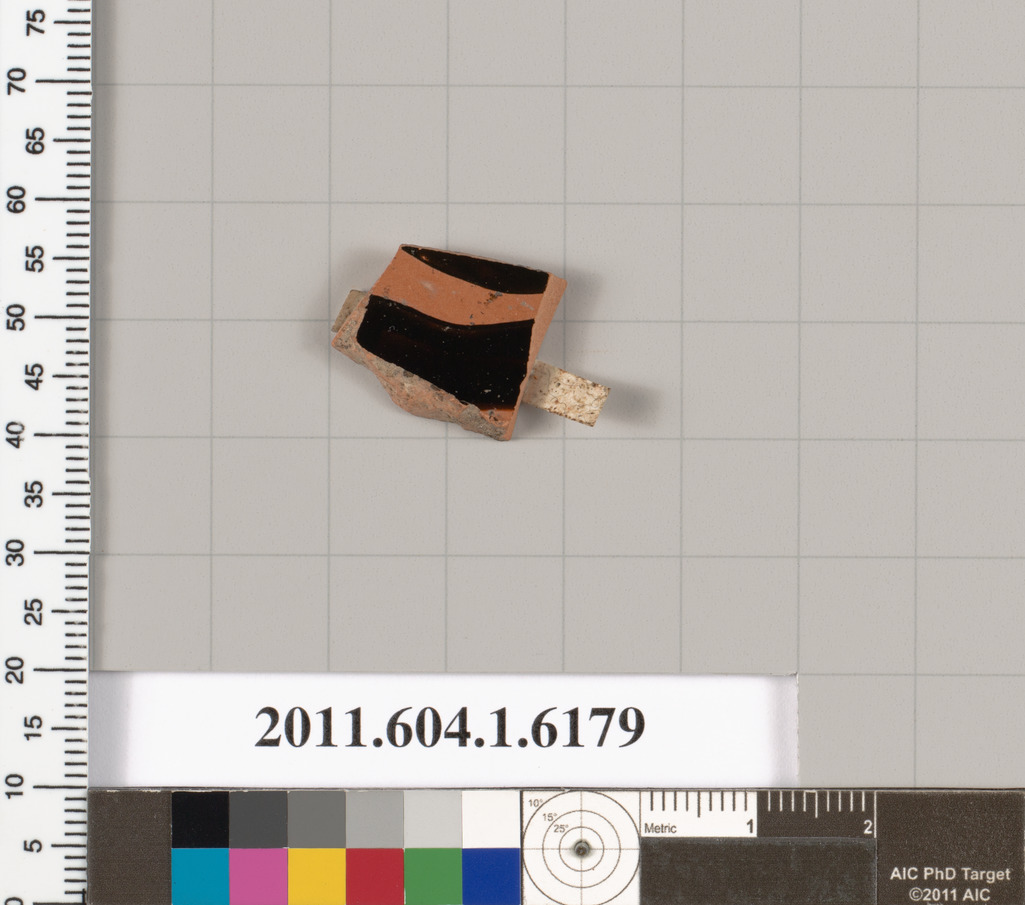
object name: kylix fragment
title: Terracotta fragment of a kylix (drinking cup)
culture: greek, attic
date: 520-500 BCE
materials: terracotta